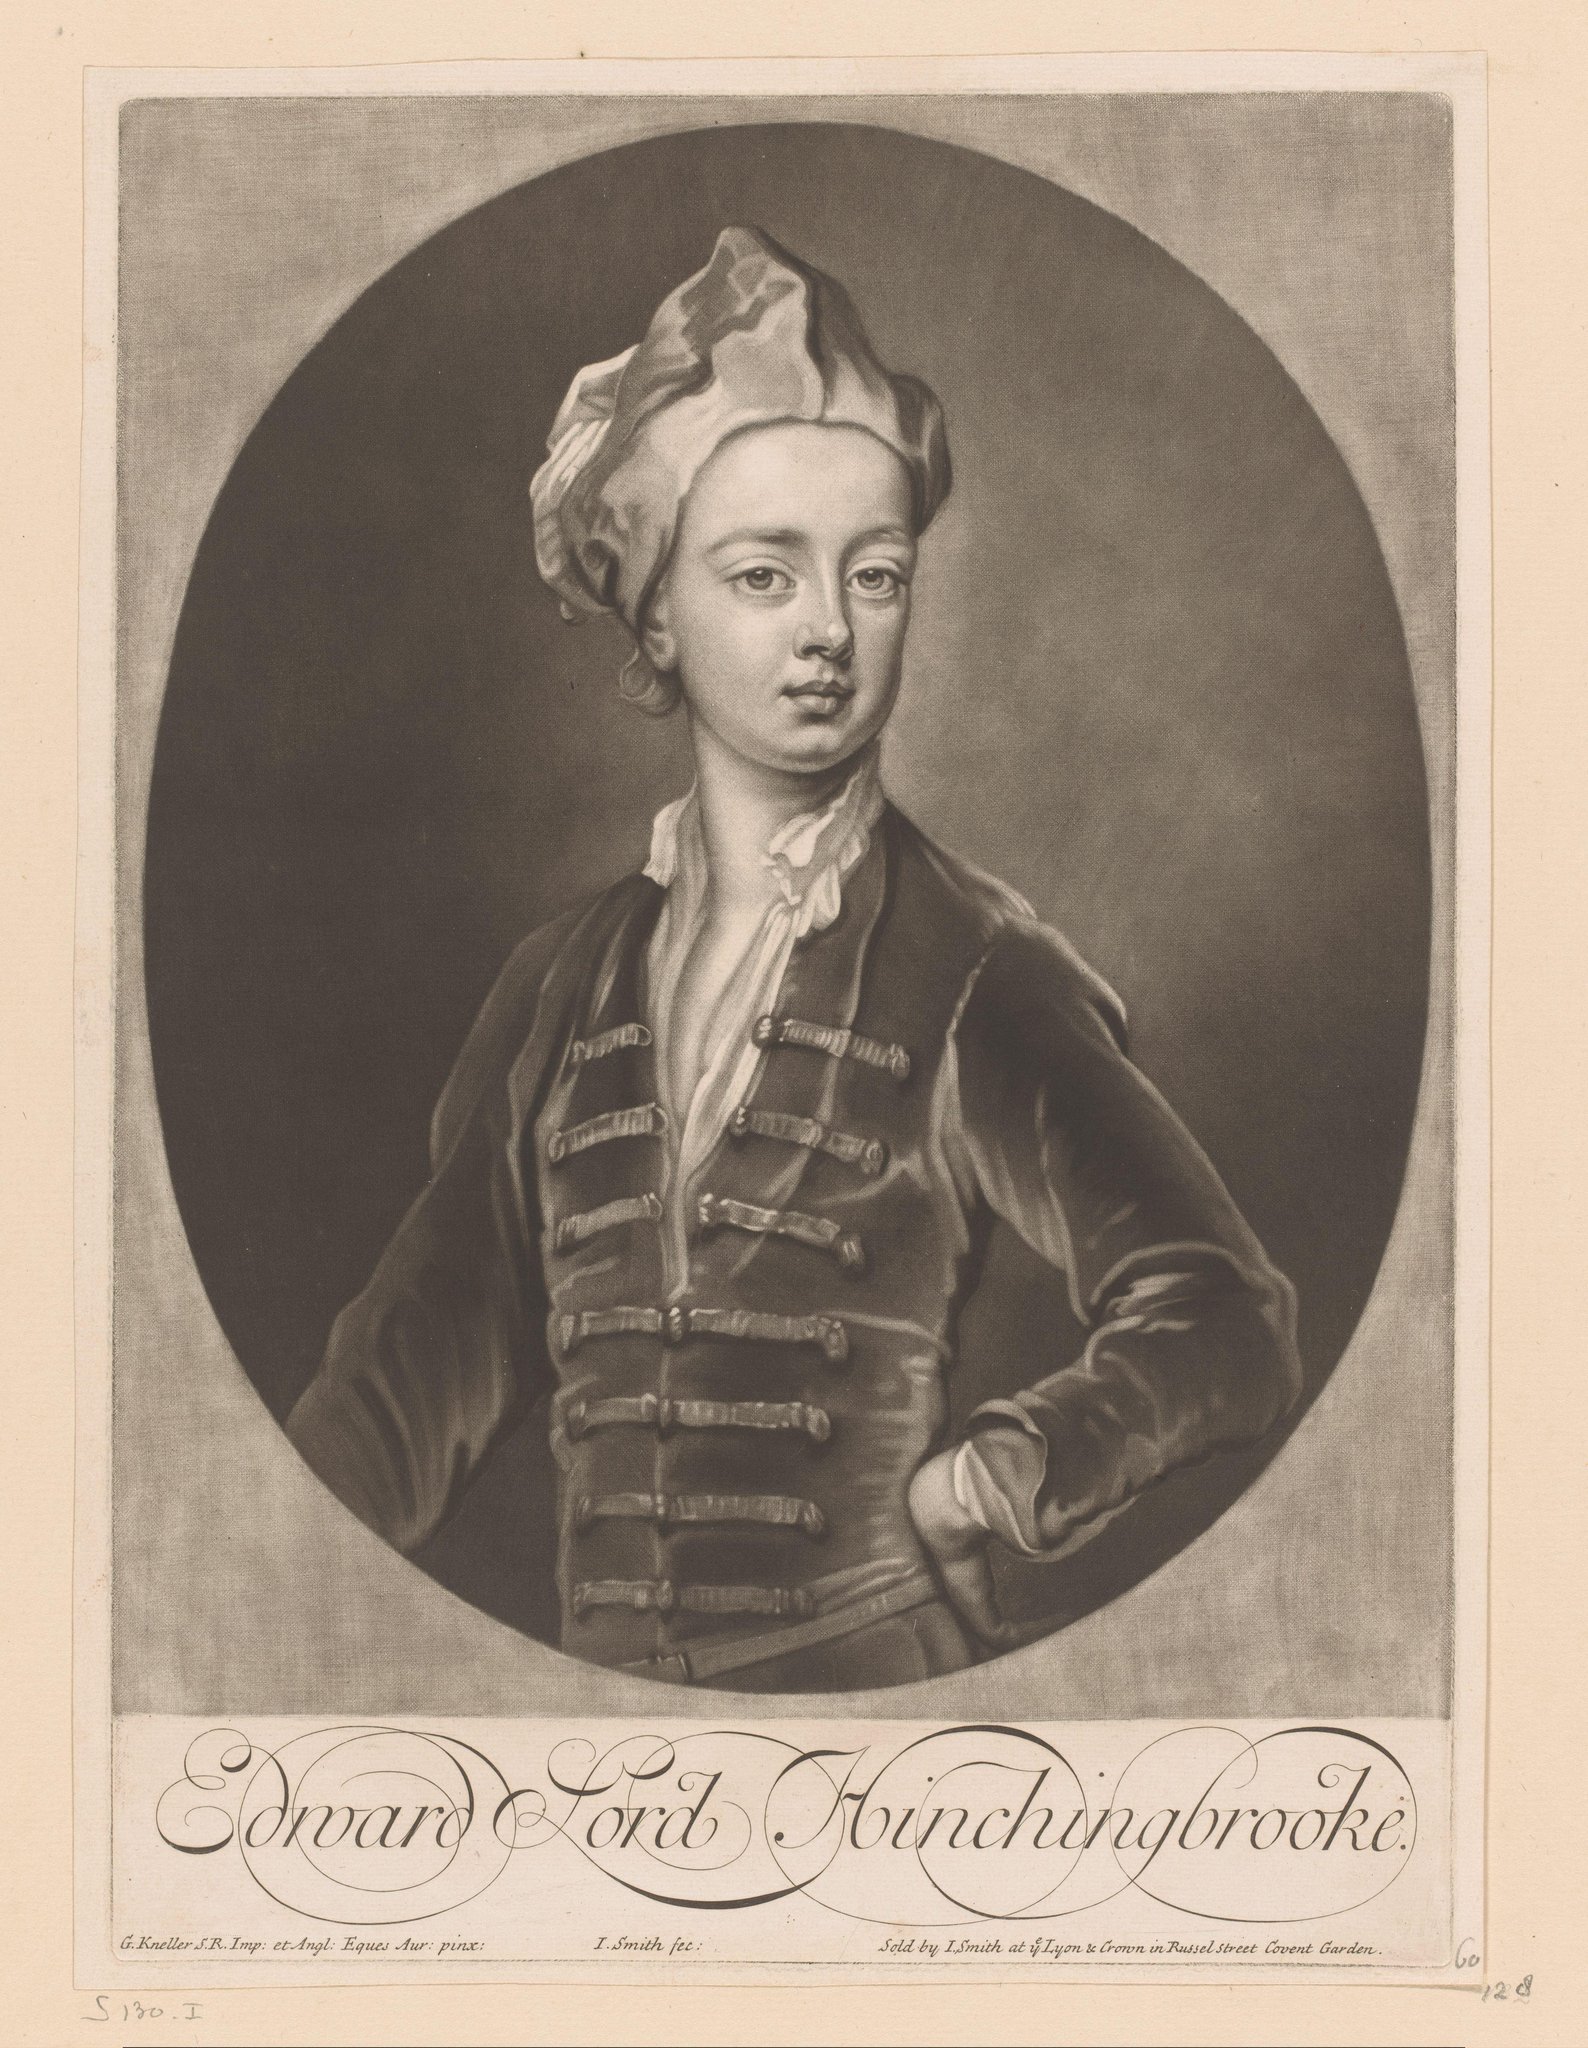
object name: print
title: Edward Lord Hinchingbrooke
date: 1700-1742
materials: paper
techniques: mezzotint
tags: politician, historical persons, politician, e.g. party leader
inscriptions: collector's mark: Lugt 240